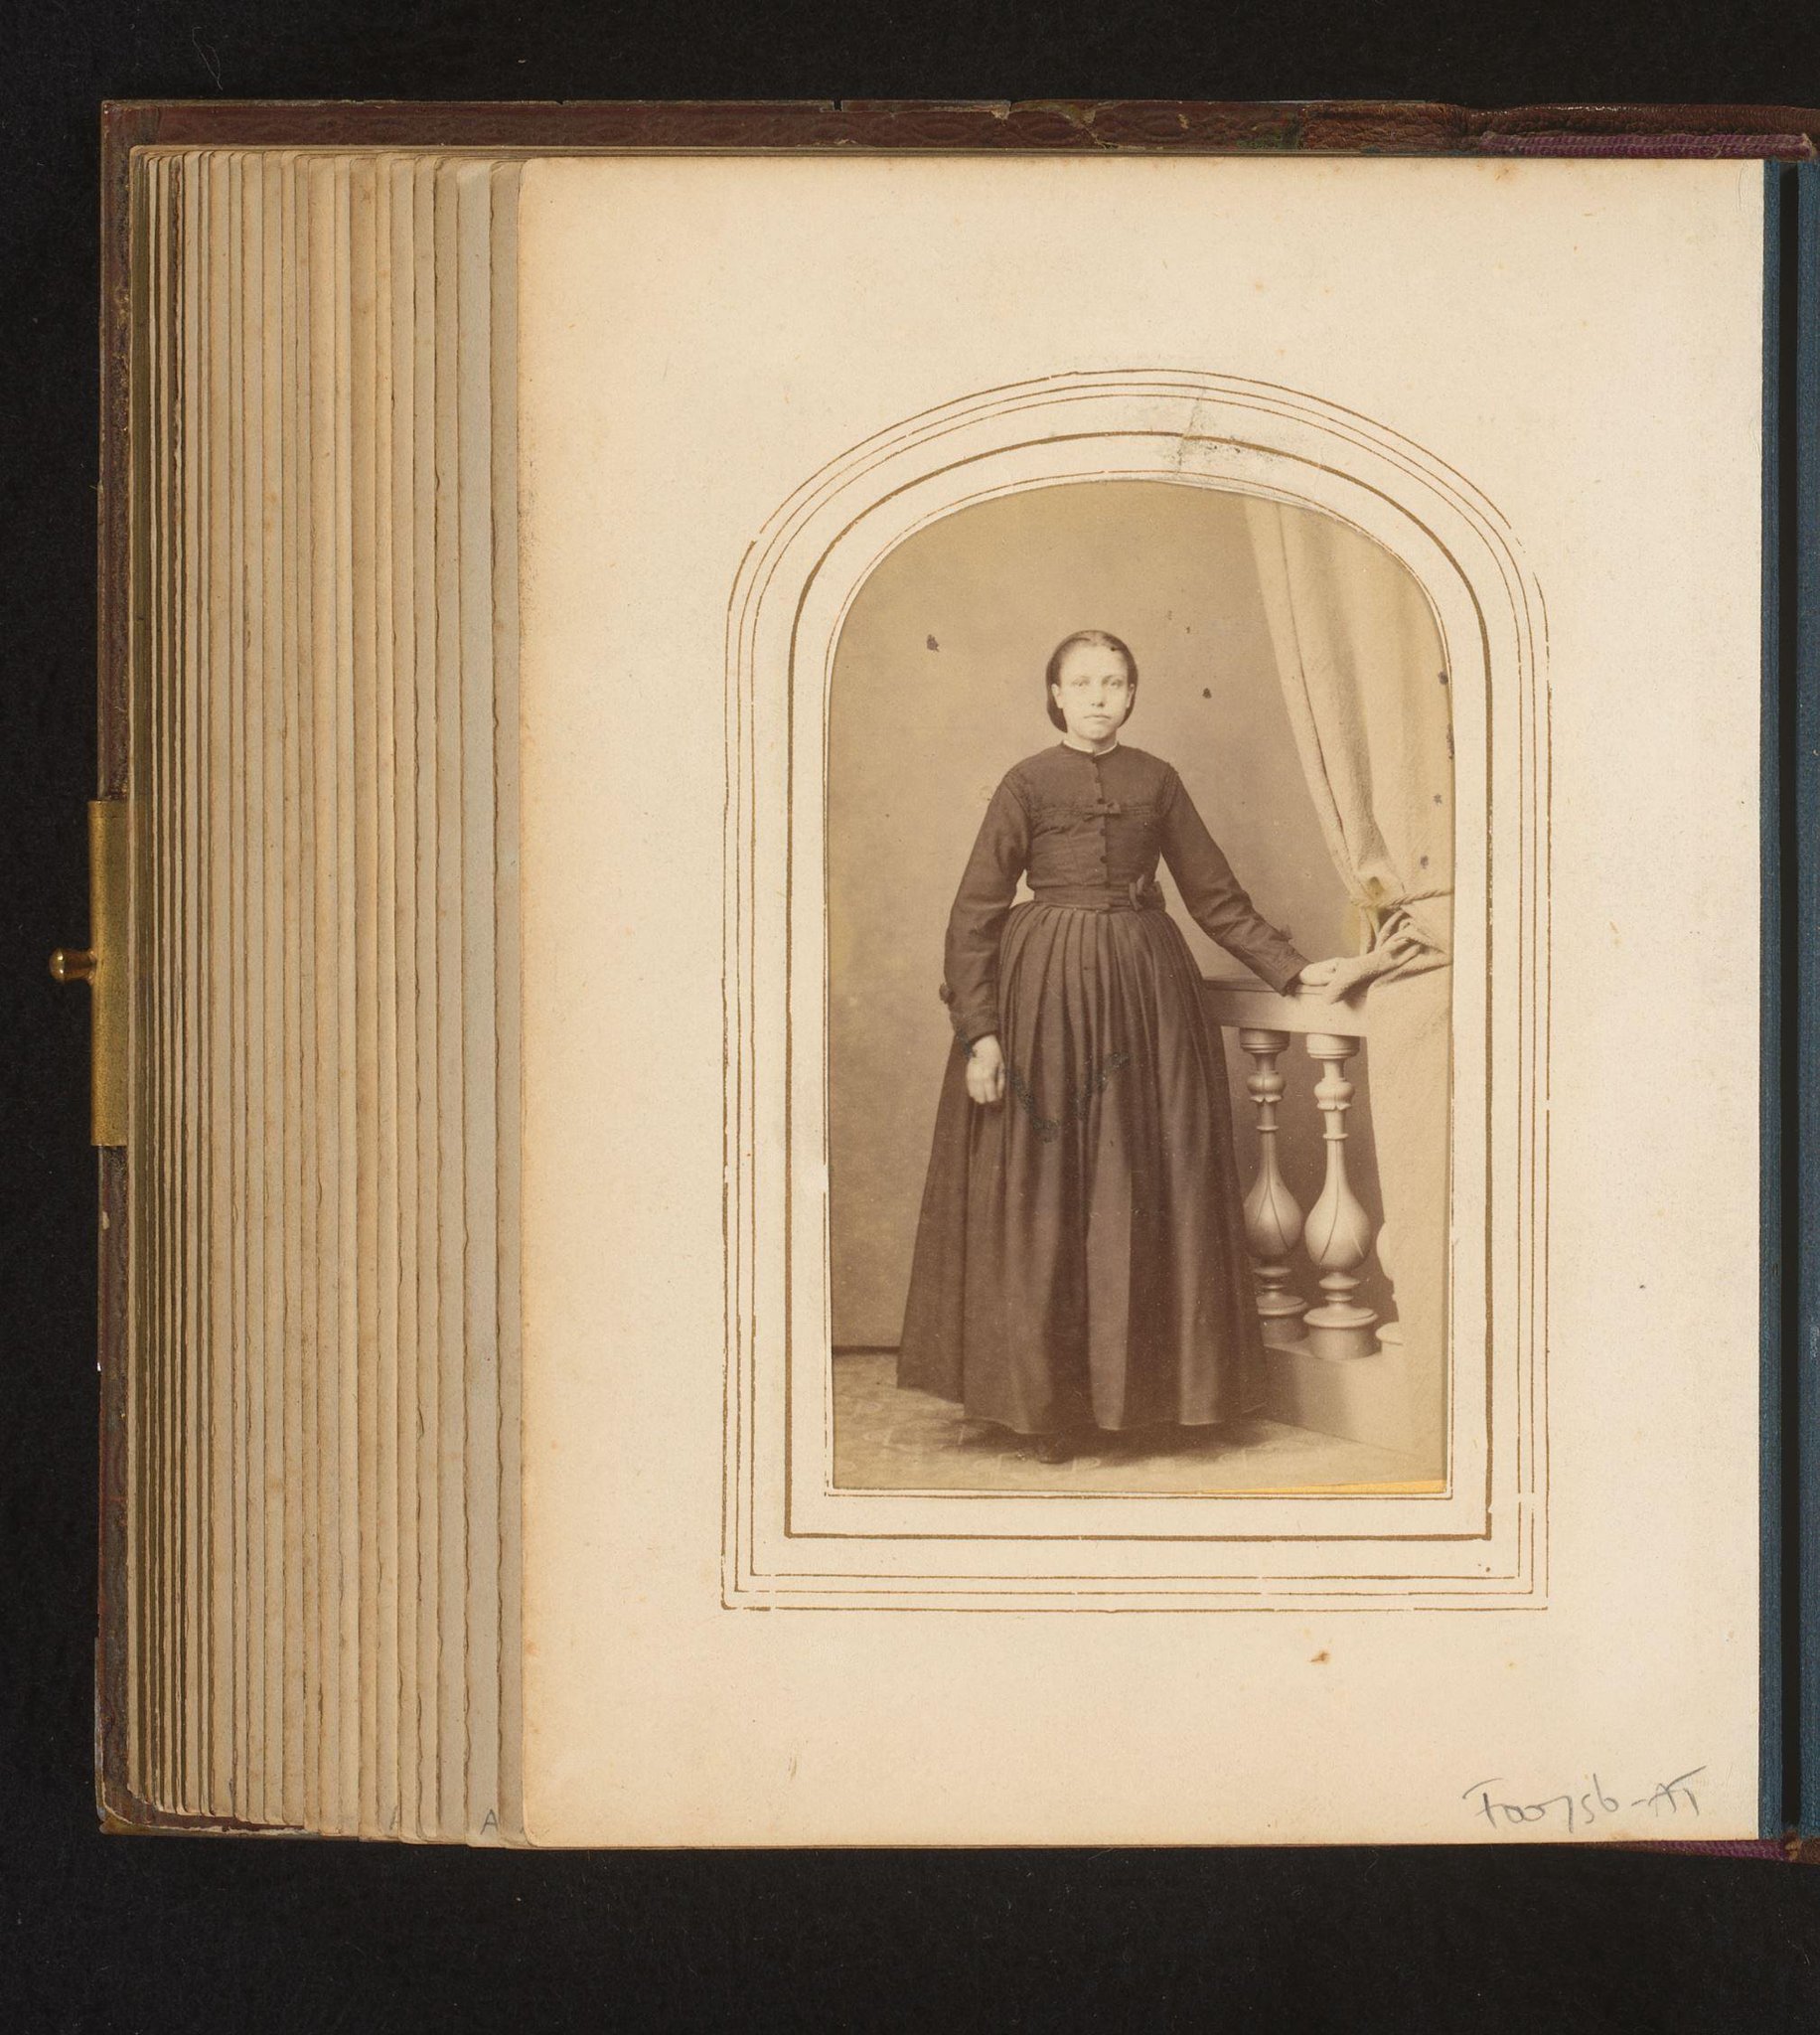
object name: carte de visite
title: Portret van een vrouw, staand bij een balustrade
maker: françois hermans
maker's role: fotograaf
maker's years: 1842-1926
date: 1857-1895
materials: cardboard, photographic support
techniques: albumen print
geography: rotterdam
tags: historical persons - bb - woman, balustrade, standing figure - aa - female human figure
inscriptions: inscription: ‘(...)/ PHOTOGRAPHISCH ATELIER/ FRANÇOIS HERMANS/ Hang 421/ Rotterdam/ De plaat blijft ter nabestelling bewaard.’